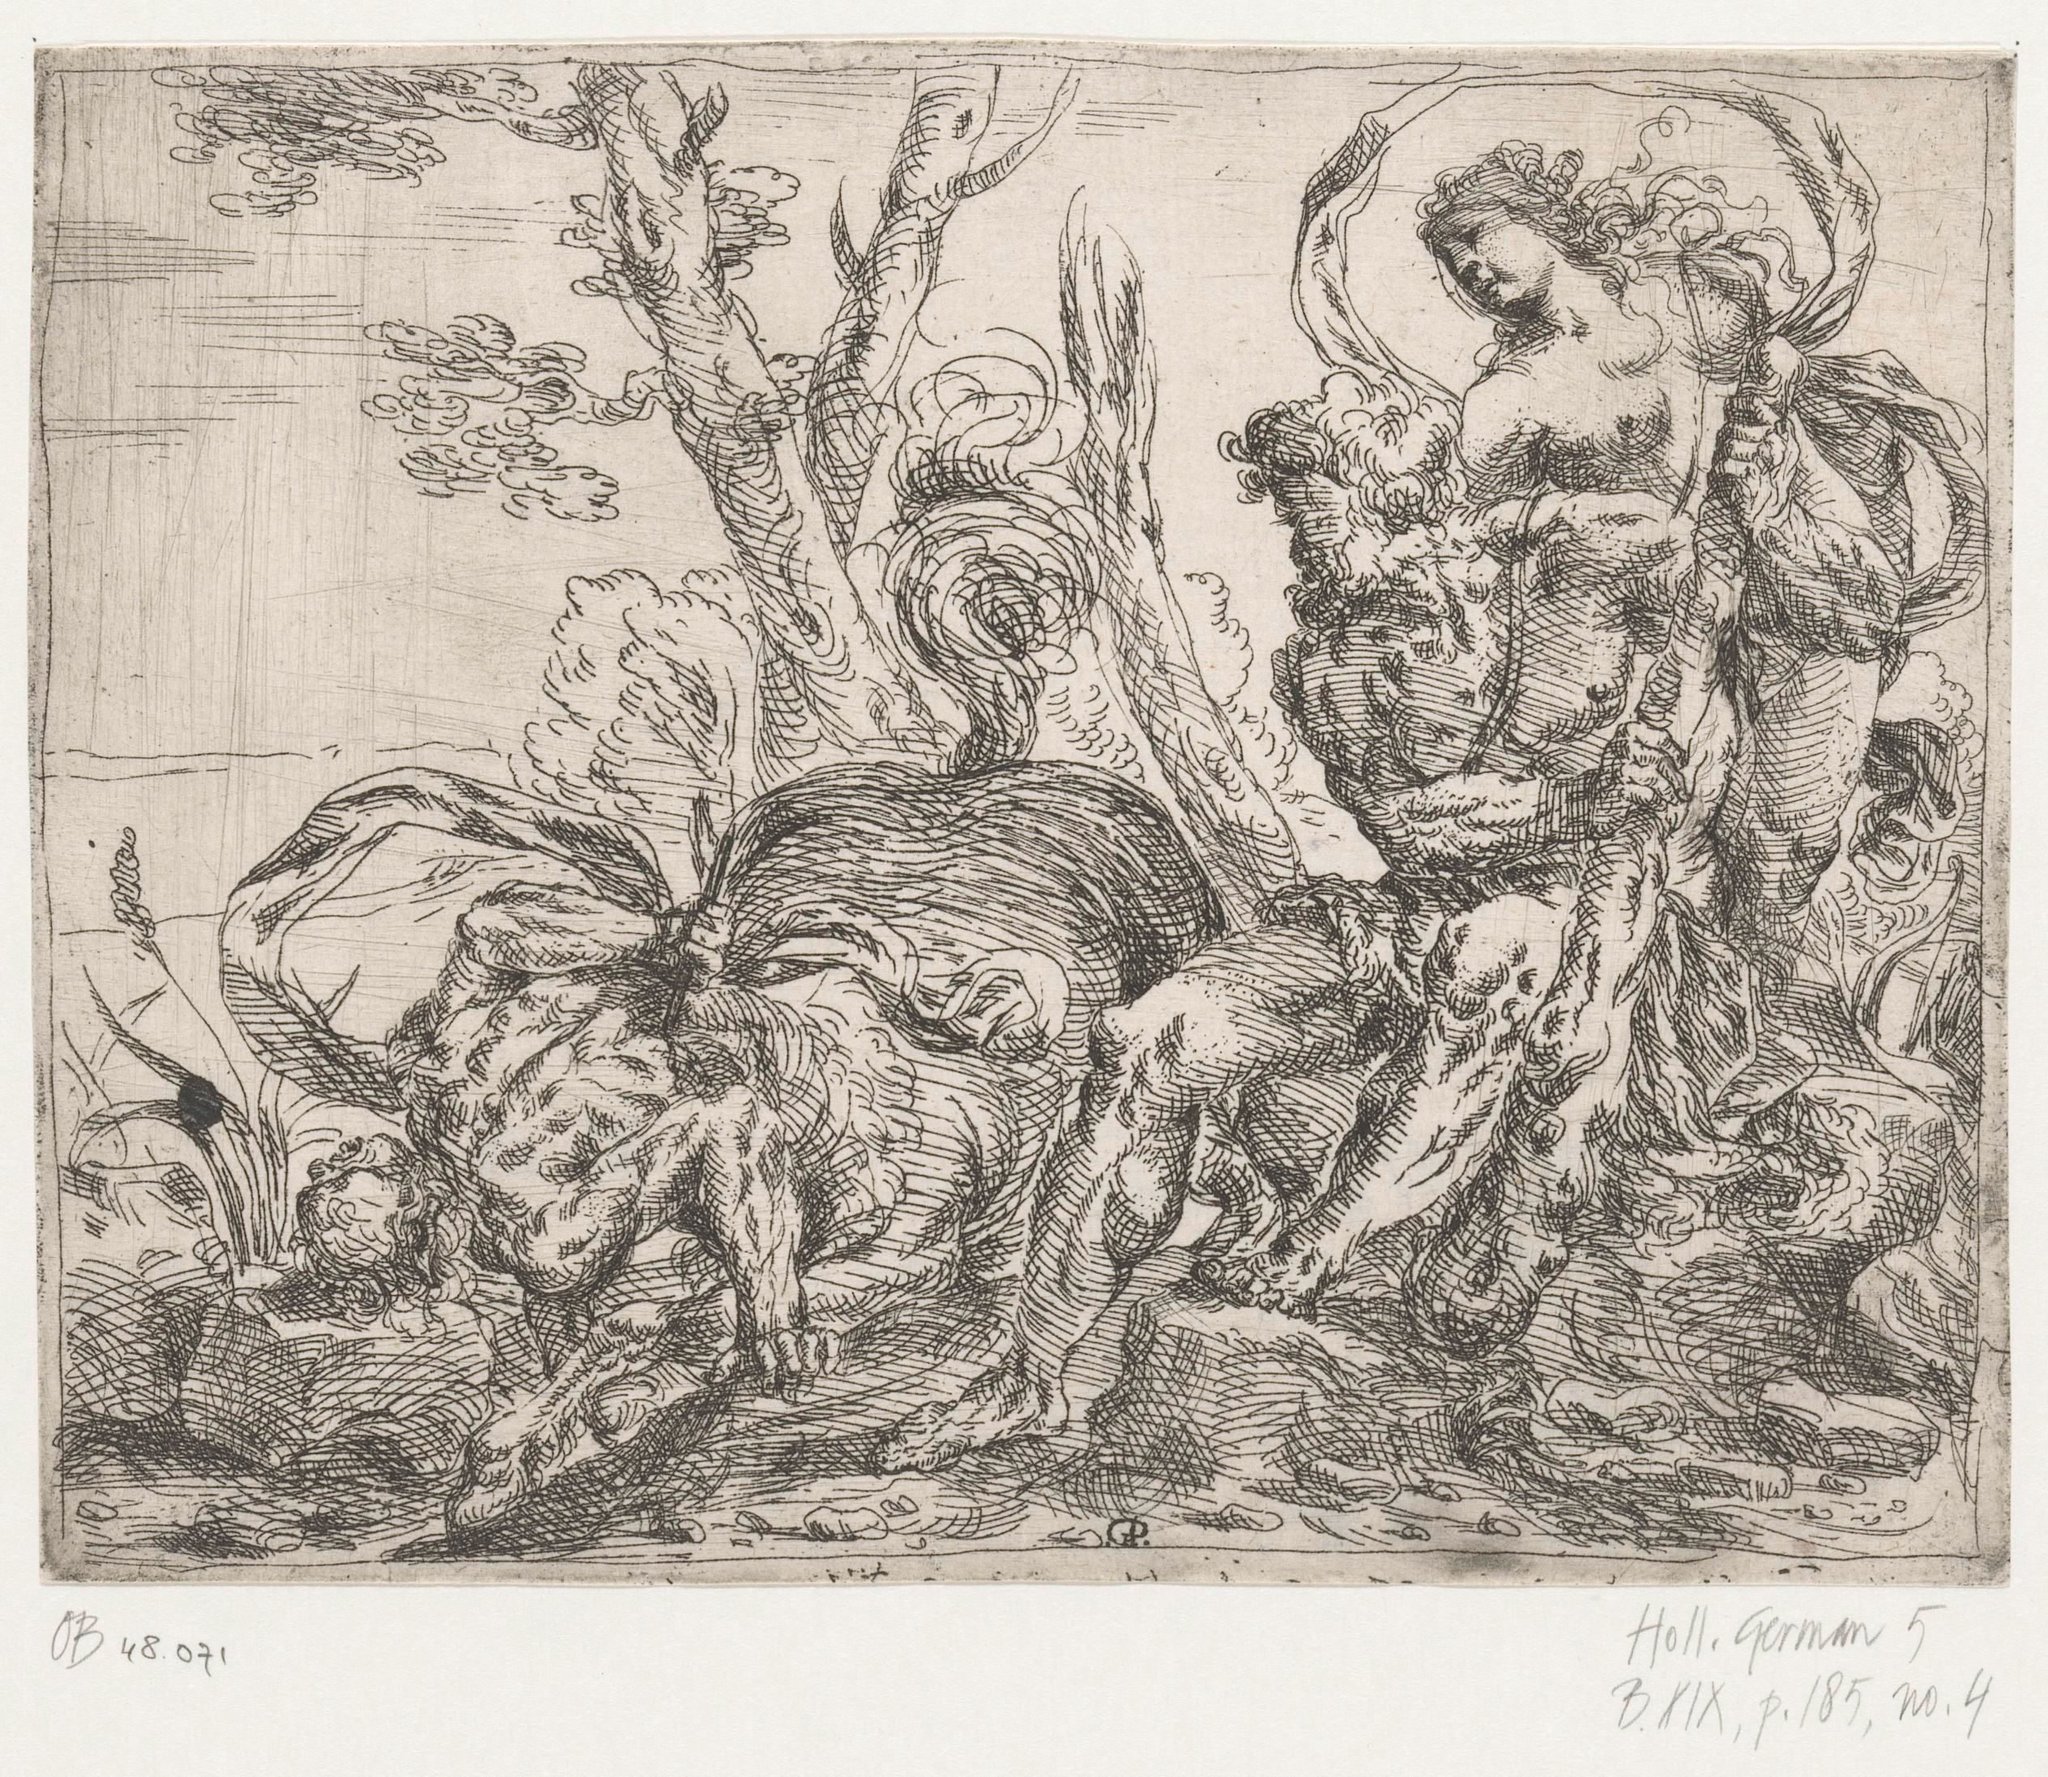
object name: print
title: Hercules doodt de centaur Nessus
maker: giovanni pietro possenti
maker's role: print maker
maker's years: 1618-1659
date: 1628-1659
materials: paper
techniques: etching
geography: italy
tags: hercules shoots nessus, the centaur, who attempts to carry off deianira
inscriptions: collector's mark: Lugt 240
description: De centaur Nessus ligt op de grond met een pijl in zijn rug. Rechts staan Hercules en Deïanira.